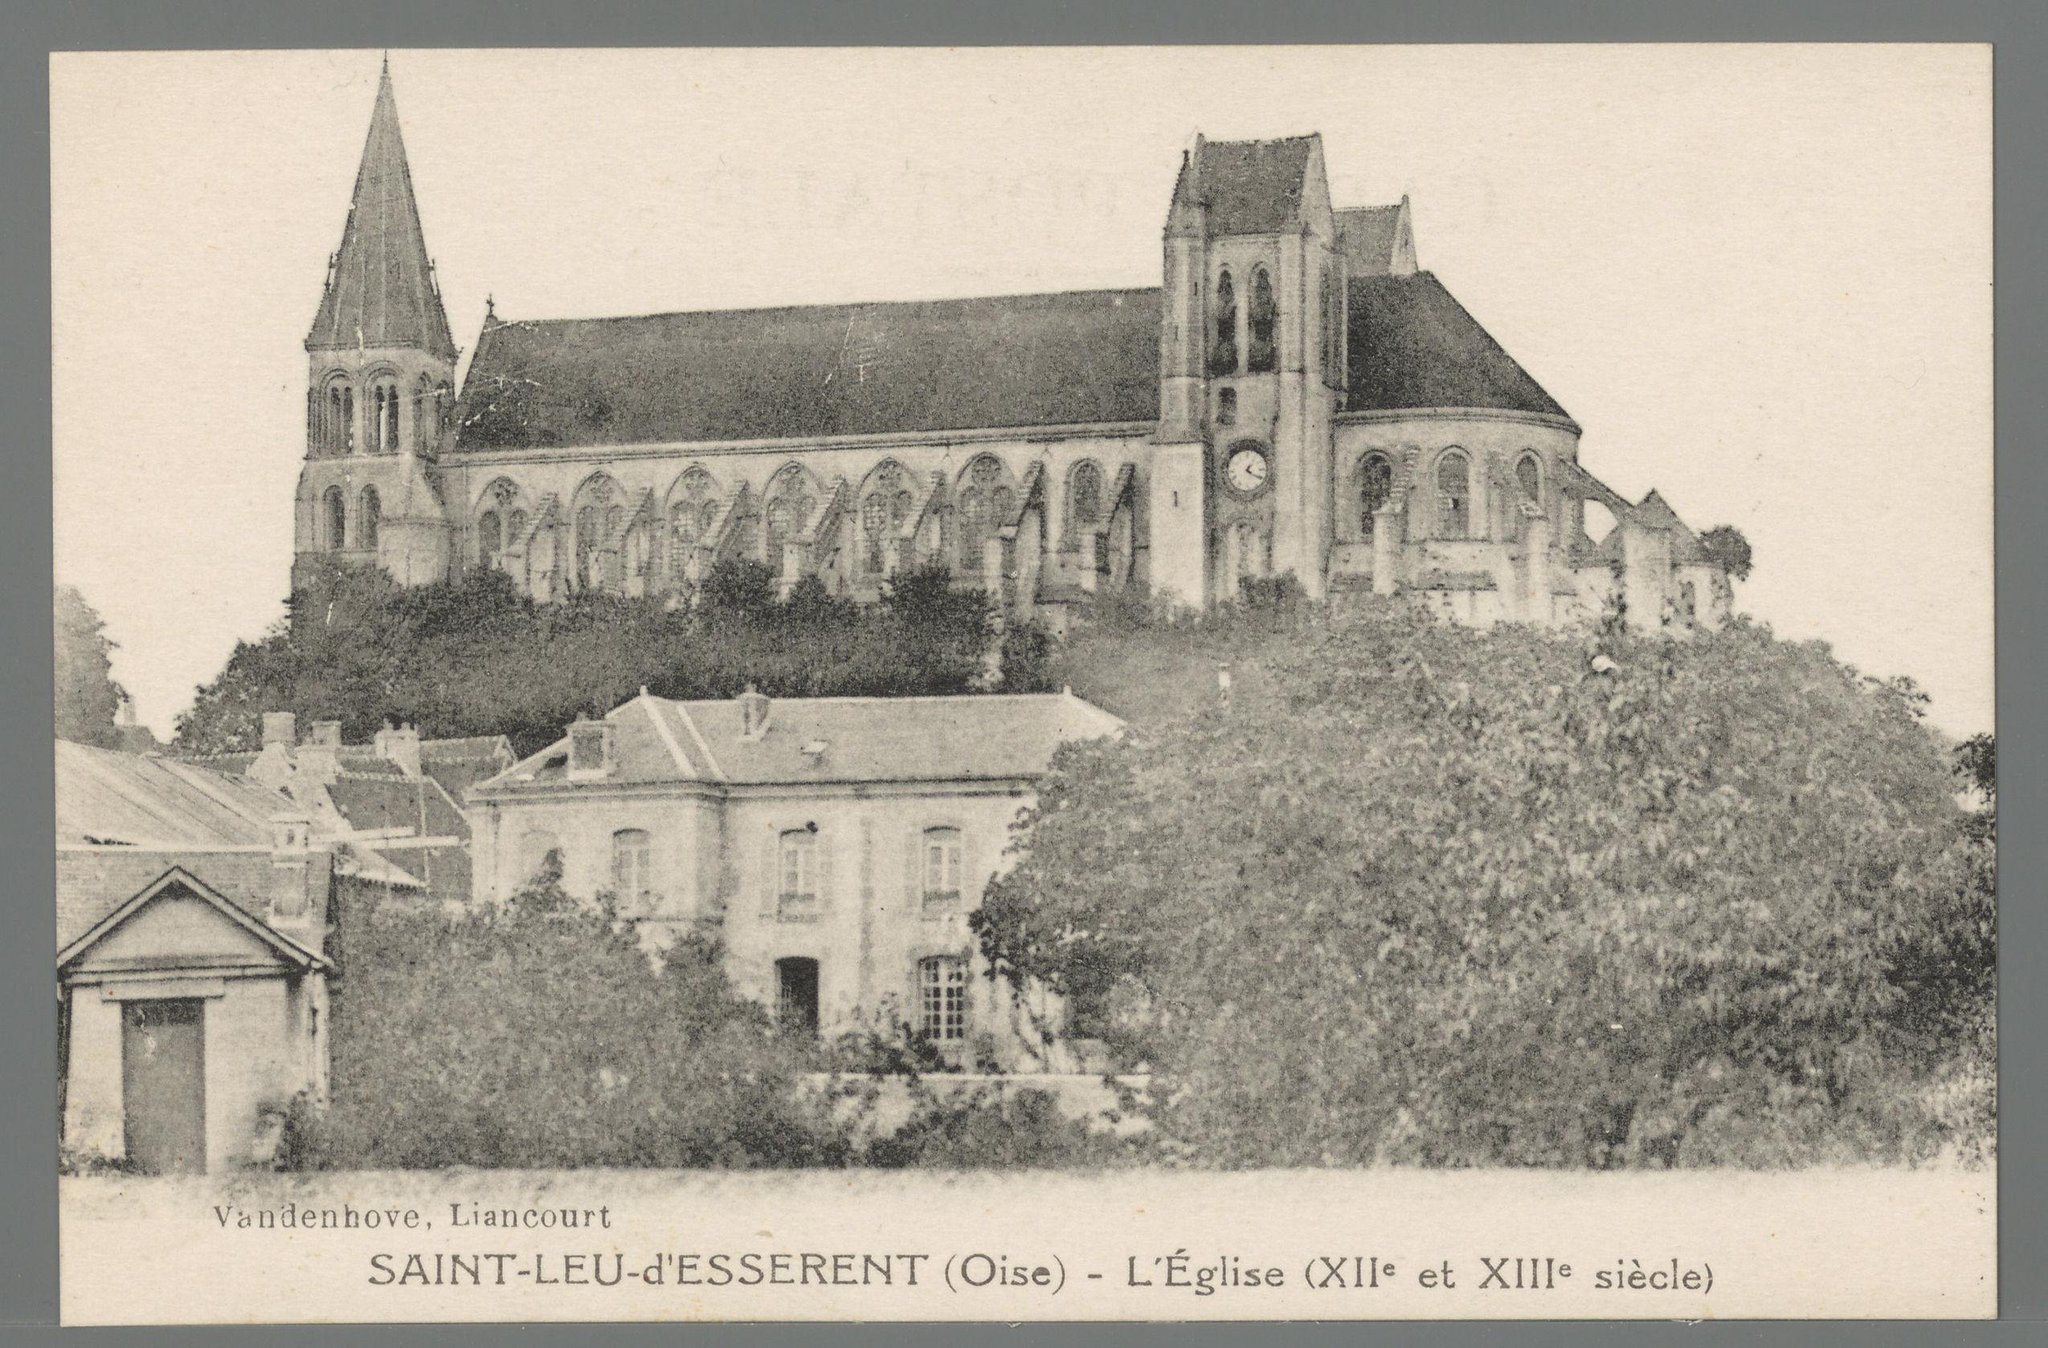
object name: ansichtkaart, prentbriefkaart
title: Saint-Leu-d'Esserent (Oise) - L'Église (XIIe et XIIIe siècle)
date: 1903-1930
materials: cardboard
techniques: photograph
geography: liancourt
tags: church (exterior)